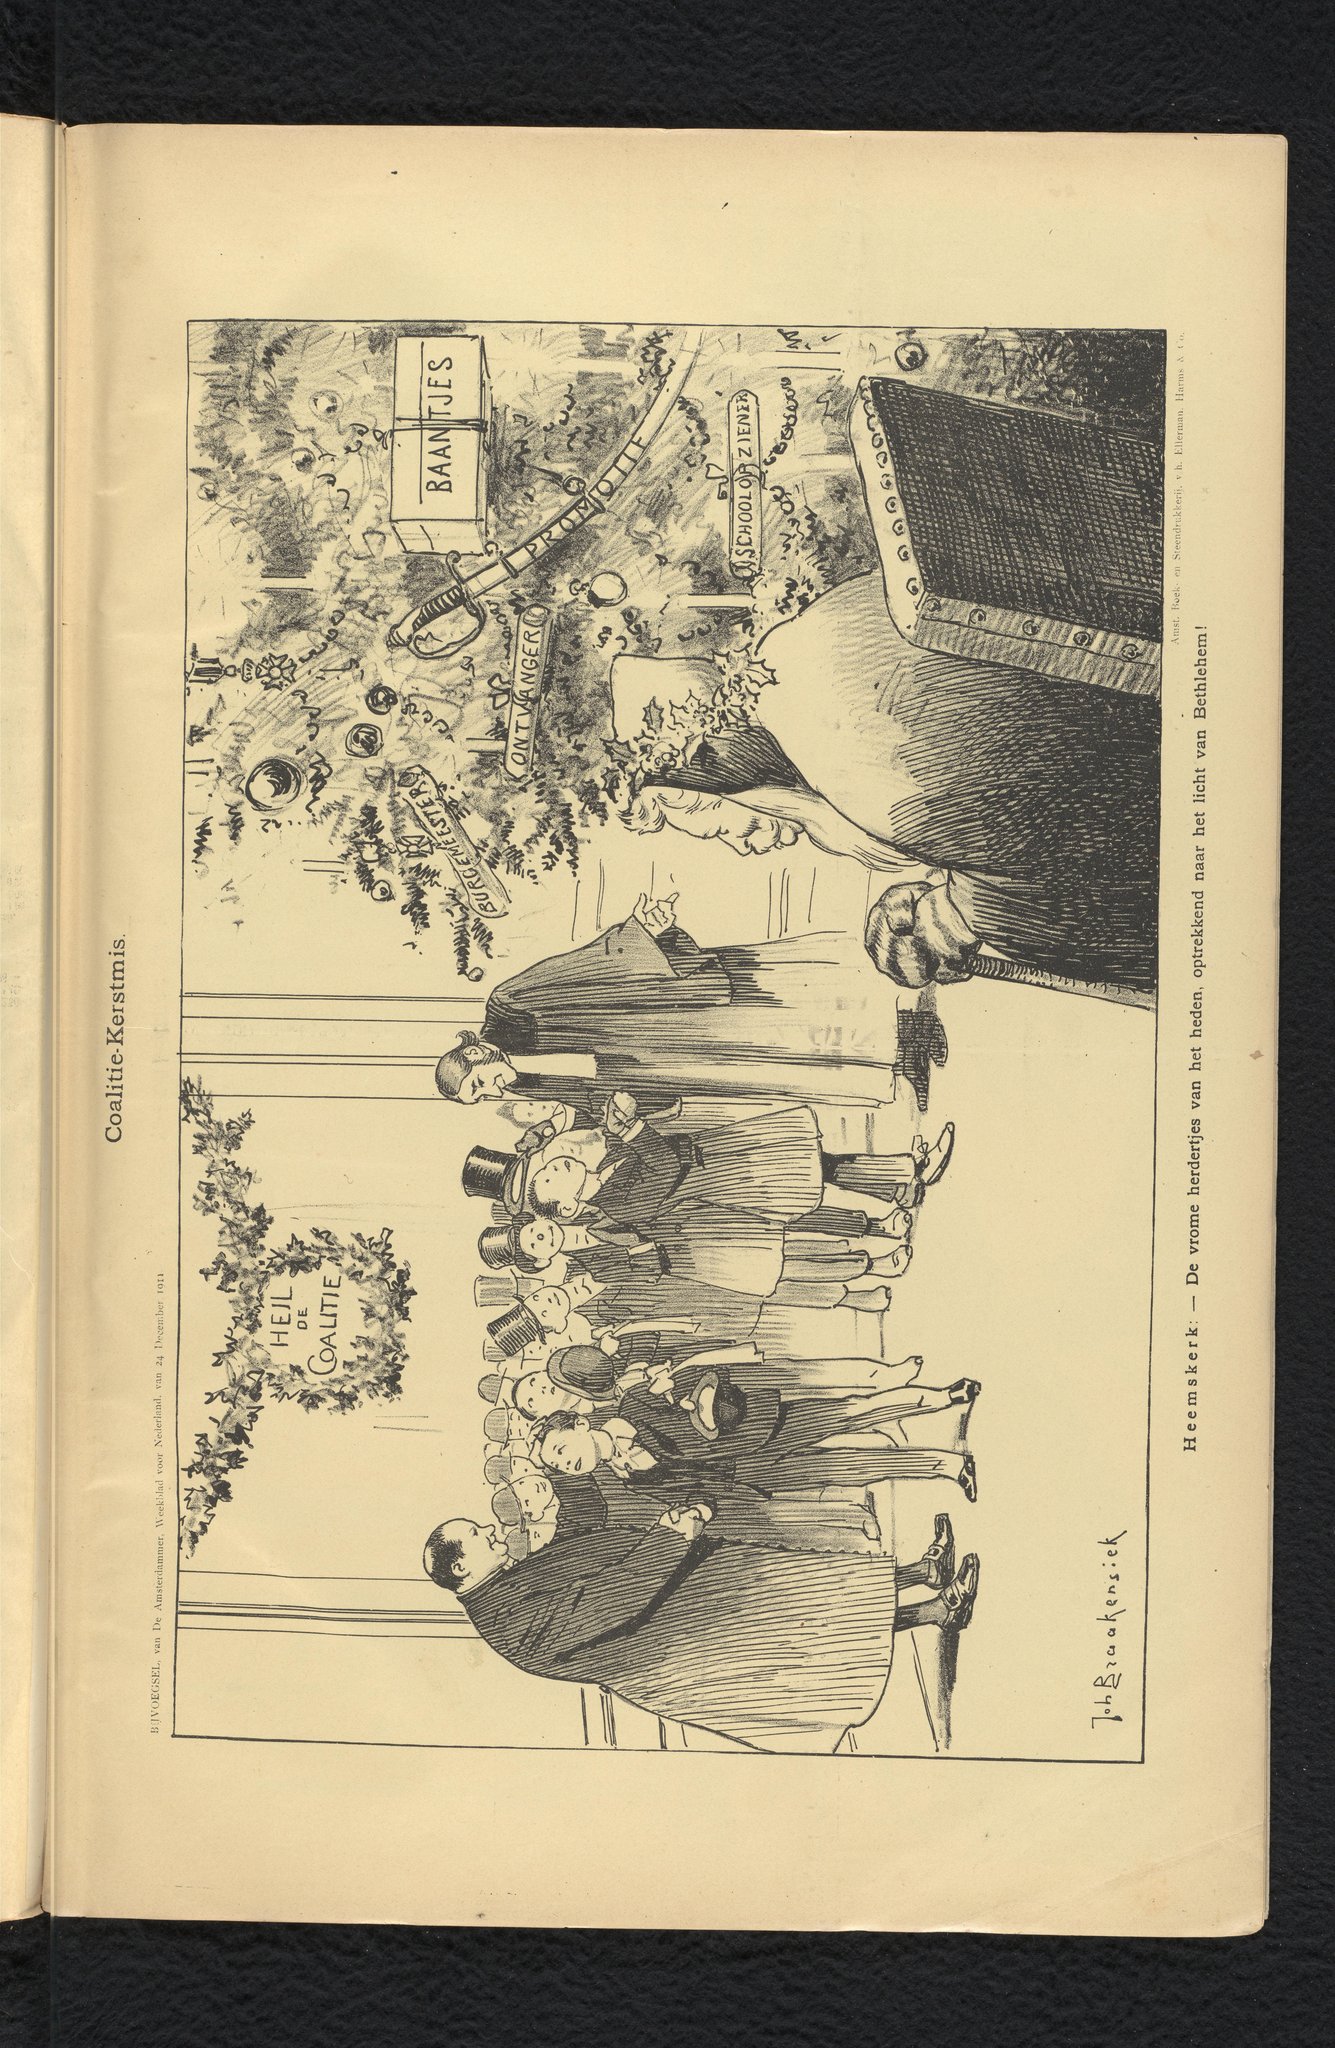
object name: cartoon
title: Coalitie-Kerstmis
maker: johan braakensiek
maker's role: draughtsman, print maker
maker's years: 1858-1940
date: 1911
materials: paper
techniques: lithograph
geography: netherlands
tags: amsterdam, utrecht, christmas tree, father christmas, santa claus, christmas elf, political parties, political caricatures and satires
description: Premier Heemskerk ziet als de kerstman toe hoe de kinderen, de katholieke en protestantse partijen in de coalitie, op het kerstfeest worden welkom geheten door een priester en een dominee. De kerstboom hangt vol met (politieke) geschenken voor beide partijen.